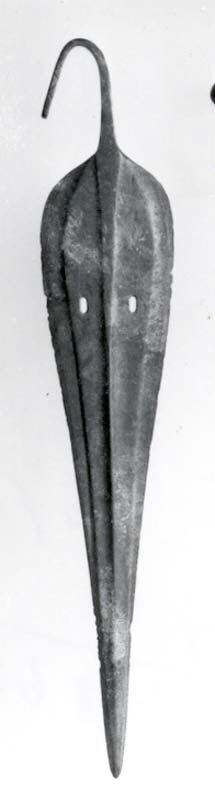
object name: spearhead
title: Spearhead with bent tang and slotted blade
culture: hattian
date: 2300-2000 BCE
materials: copper alloy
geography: central anatolia